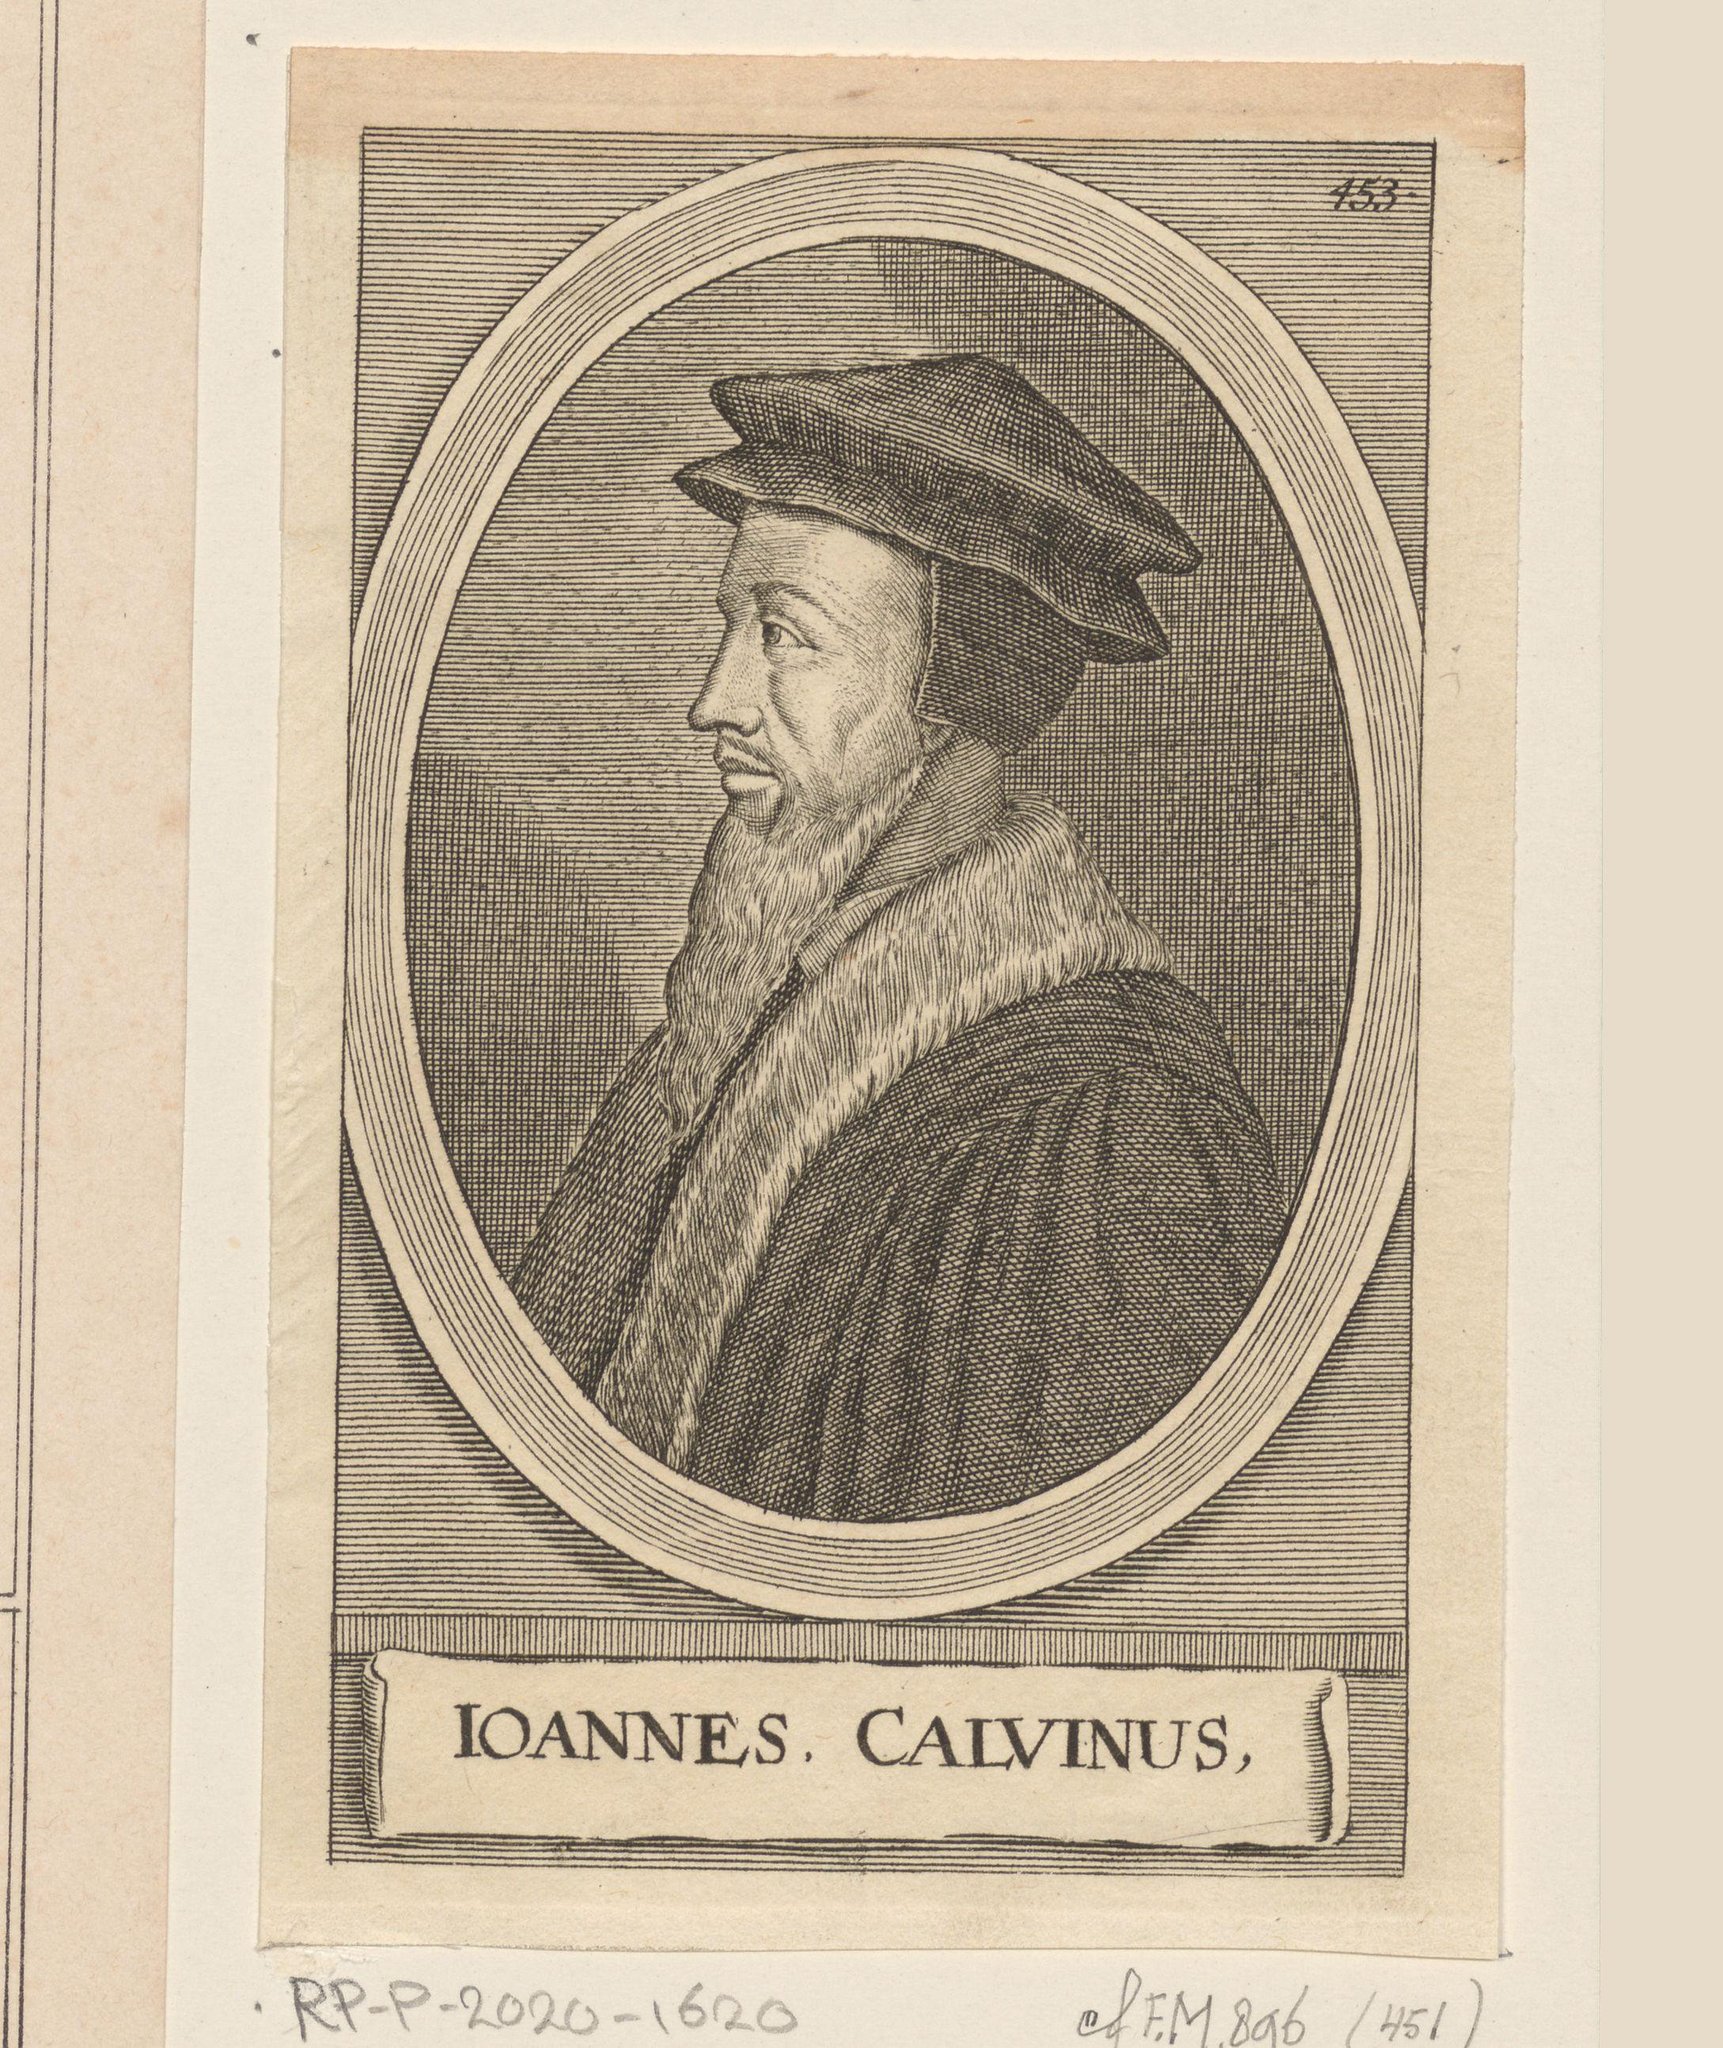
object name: print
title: Portret van Johannes Calvijn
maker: Anonymous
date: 1650-1749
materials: paper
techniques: engraving, etching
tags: historical persons